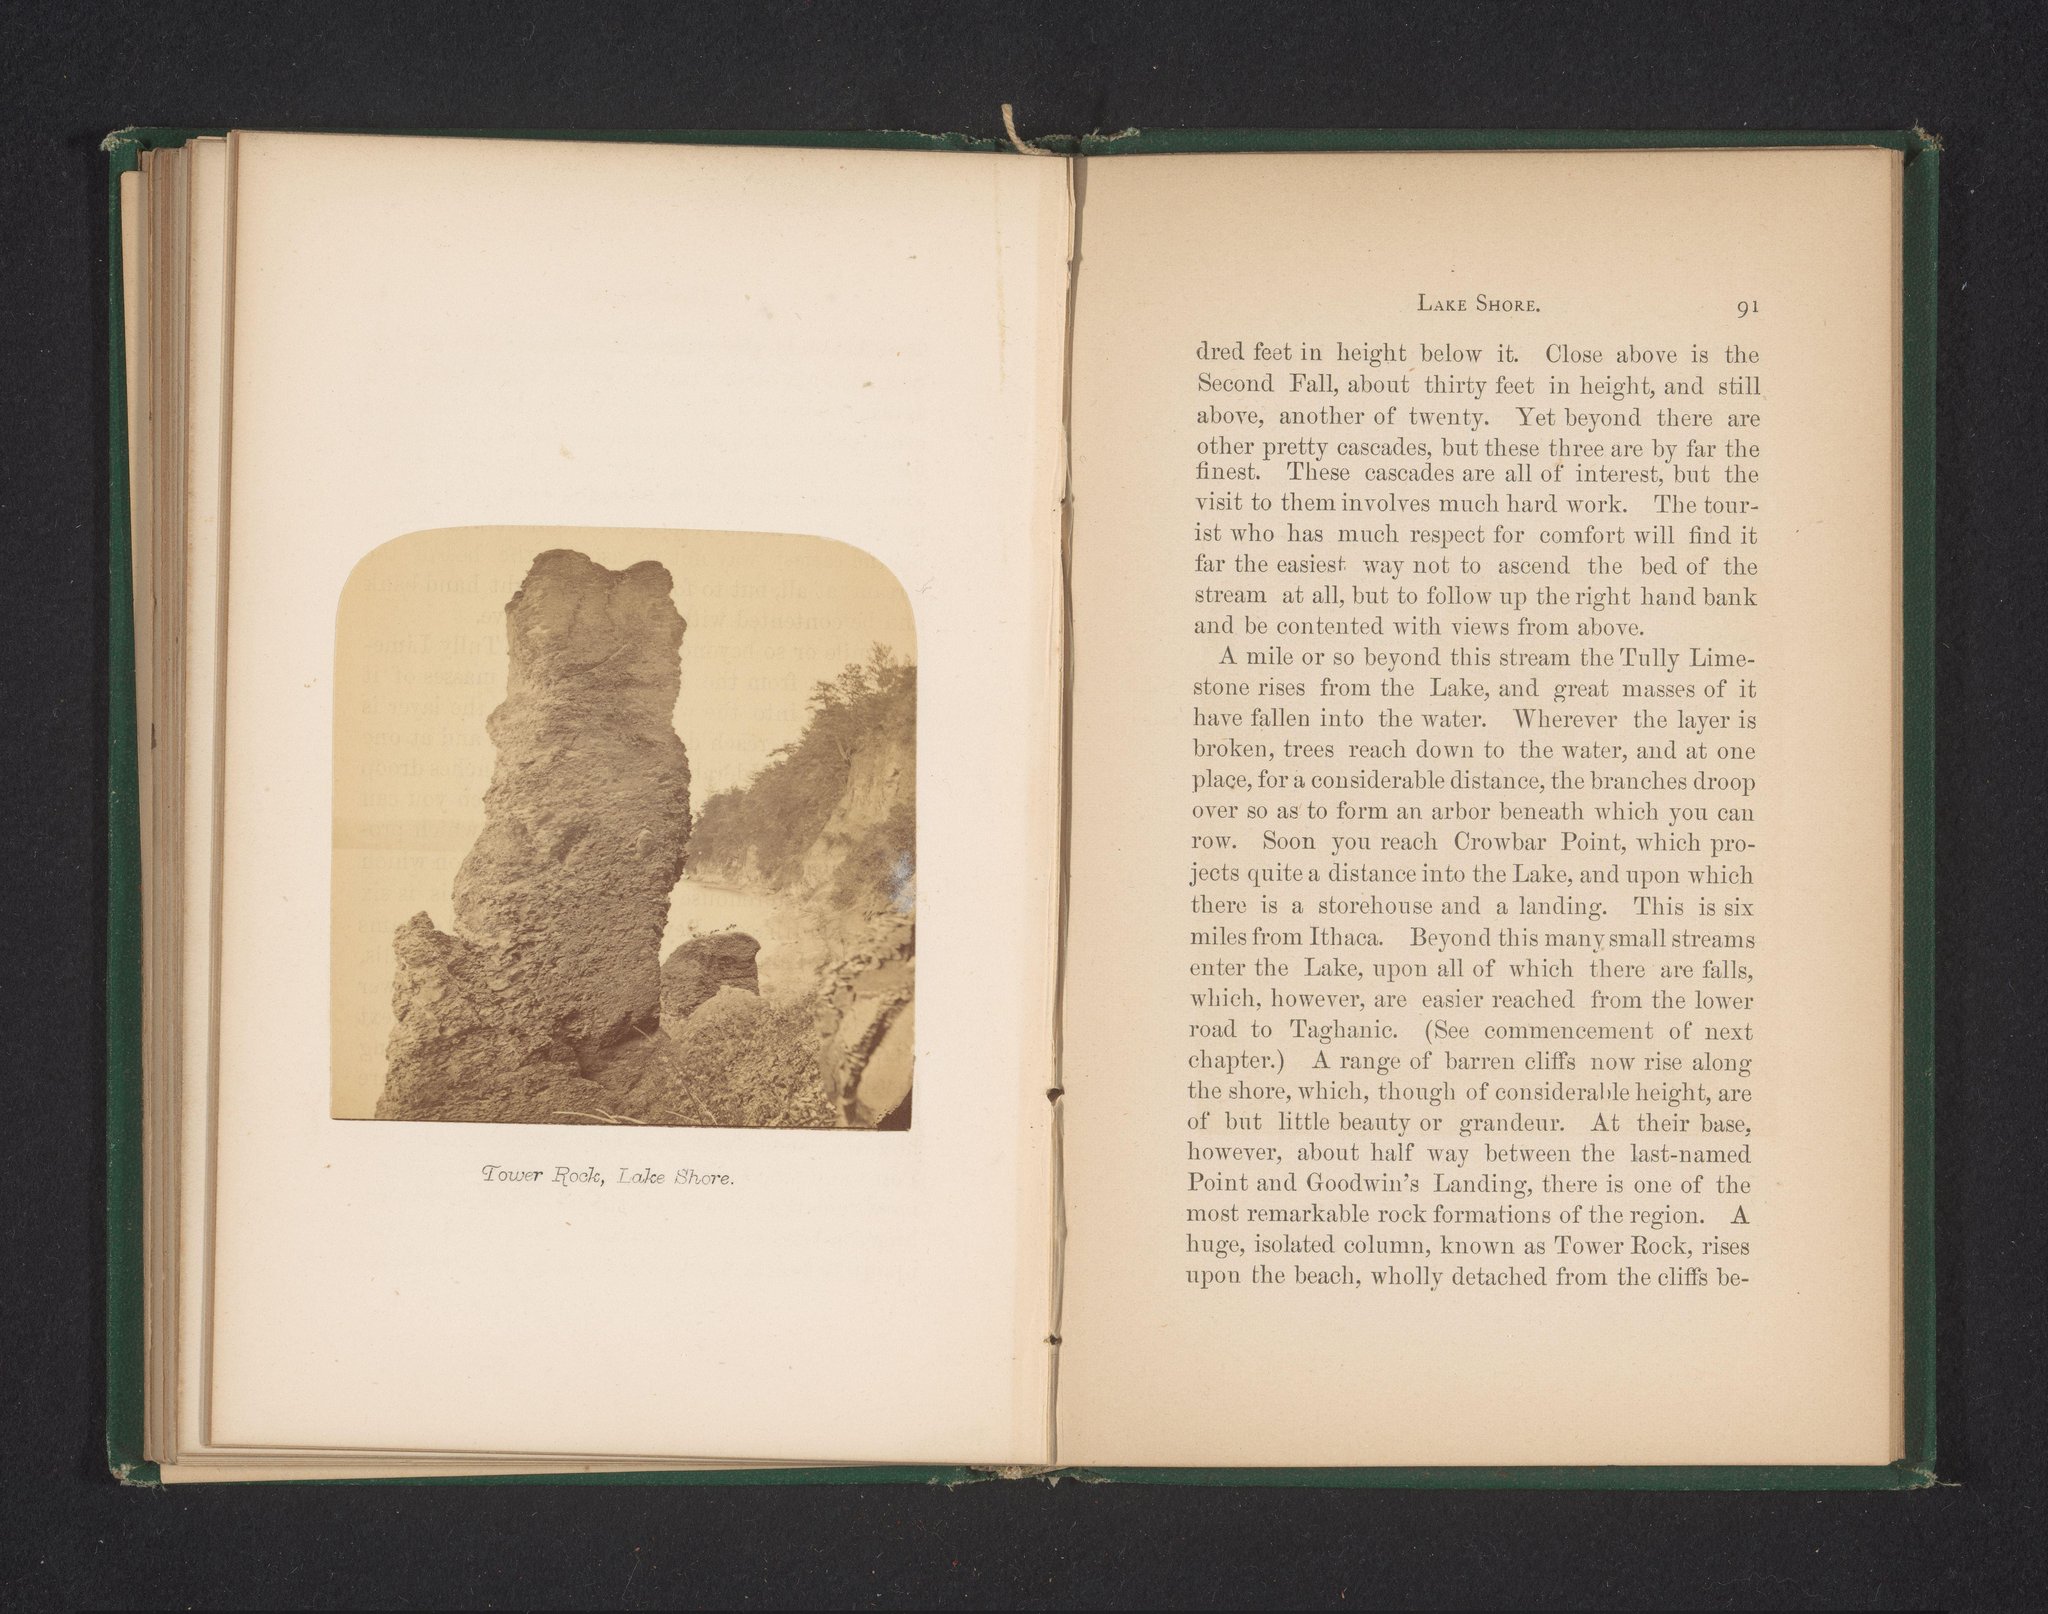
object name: photograph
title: Tower Rock, Lake Shore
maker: joseph curtiss burritt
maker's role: fotograaf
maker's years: 1817-1889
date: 1864-1869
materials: photographic support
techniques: albumen print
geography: new york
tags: rock-formations